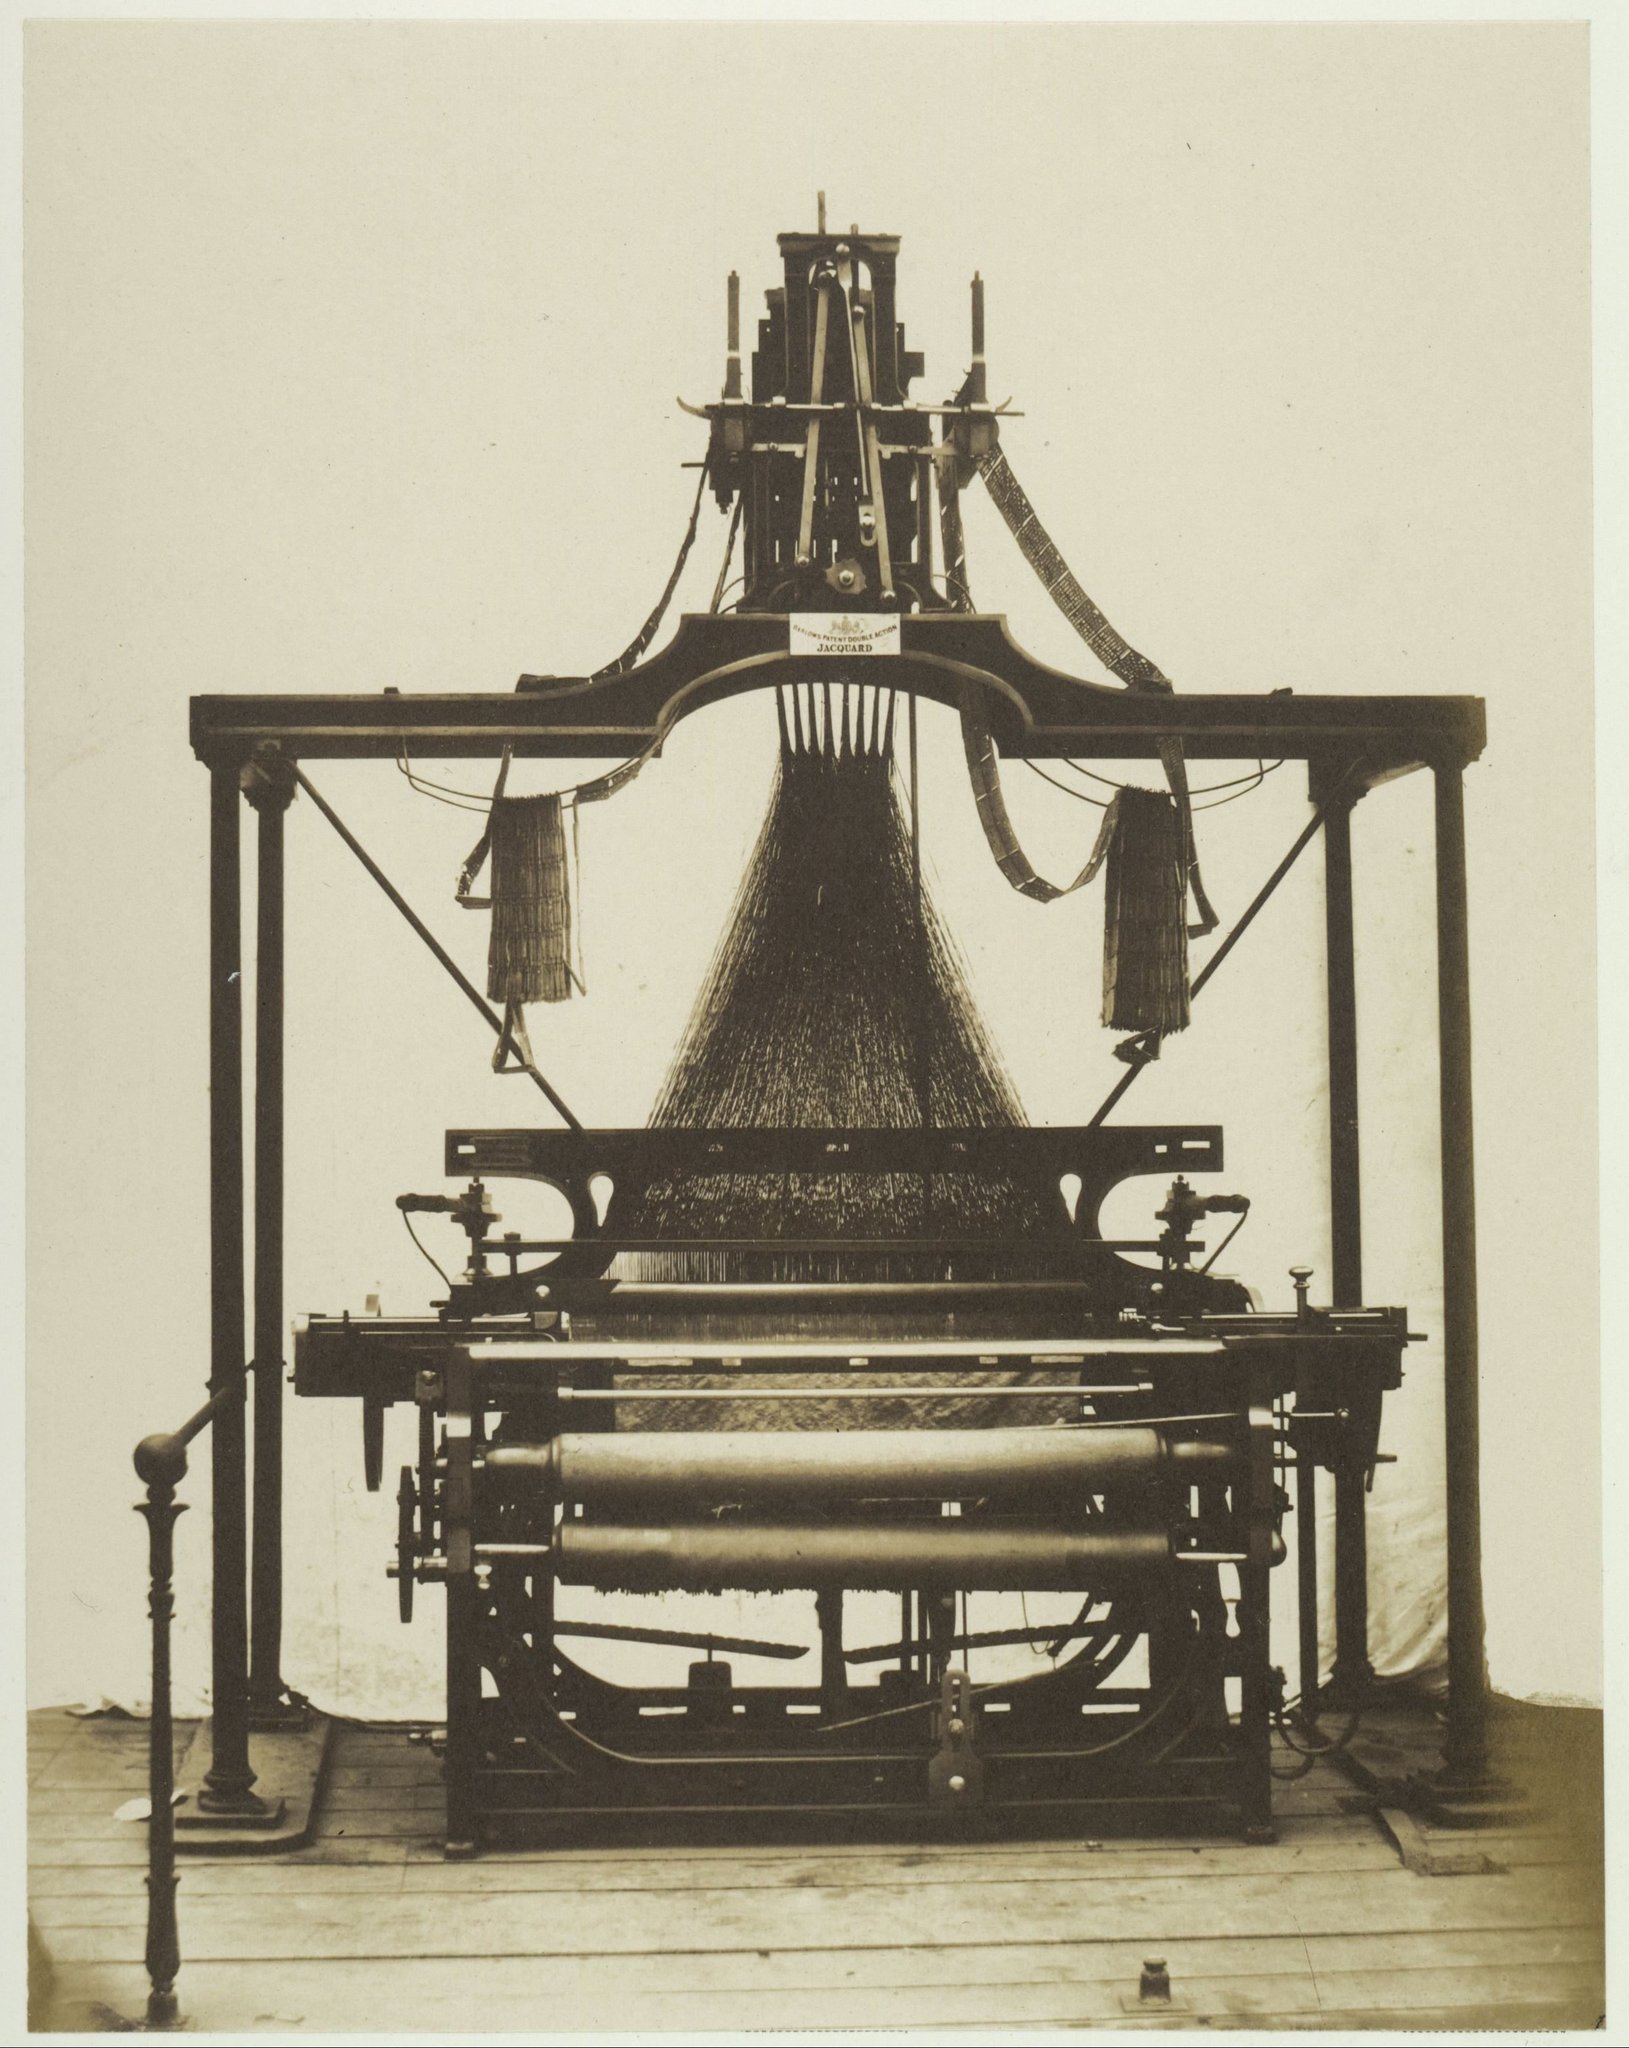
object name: photograph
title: Double Jacquard Loom. Barlow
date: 1851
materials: photographic support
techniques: salted paper print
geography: london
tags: weaving-loom, london